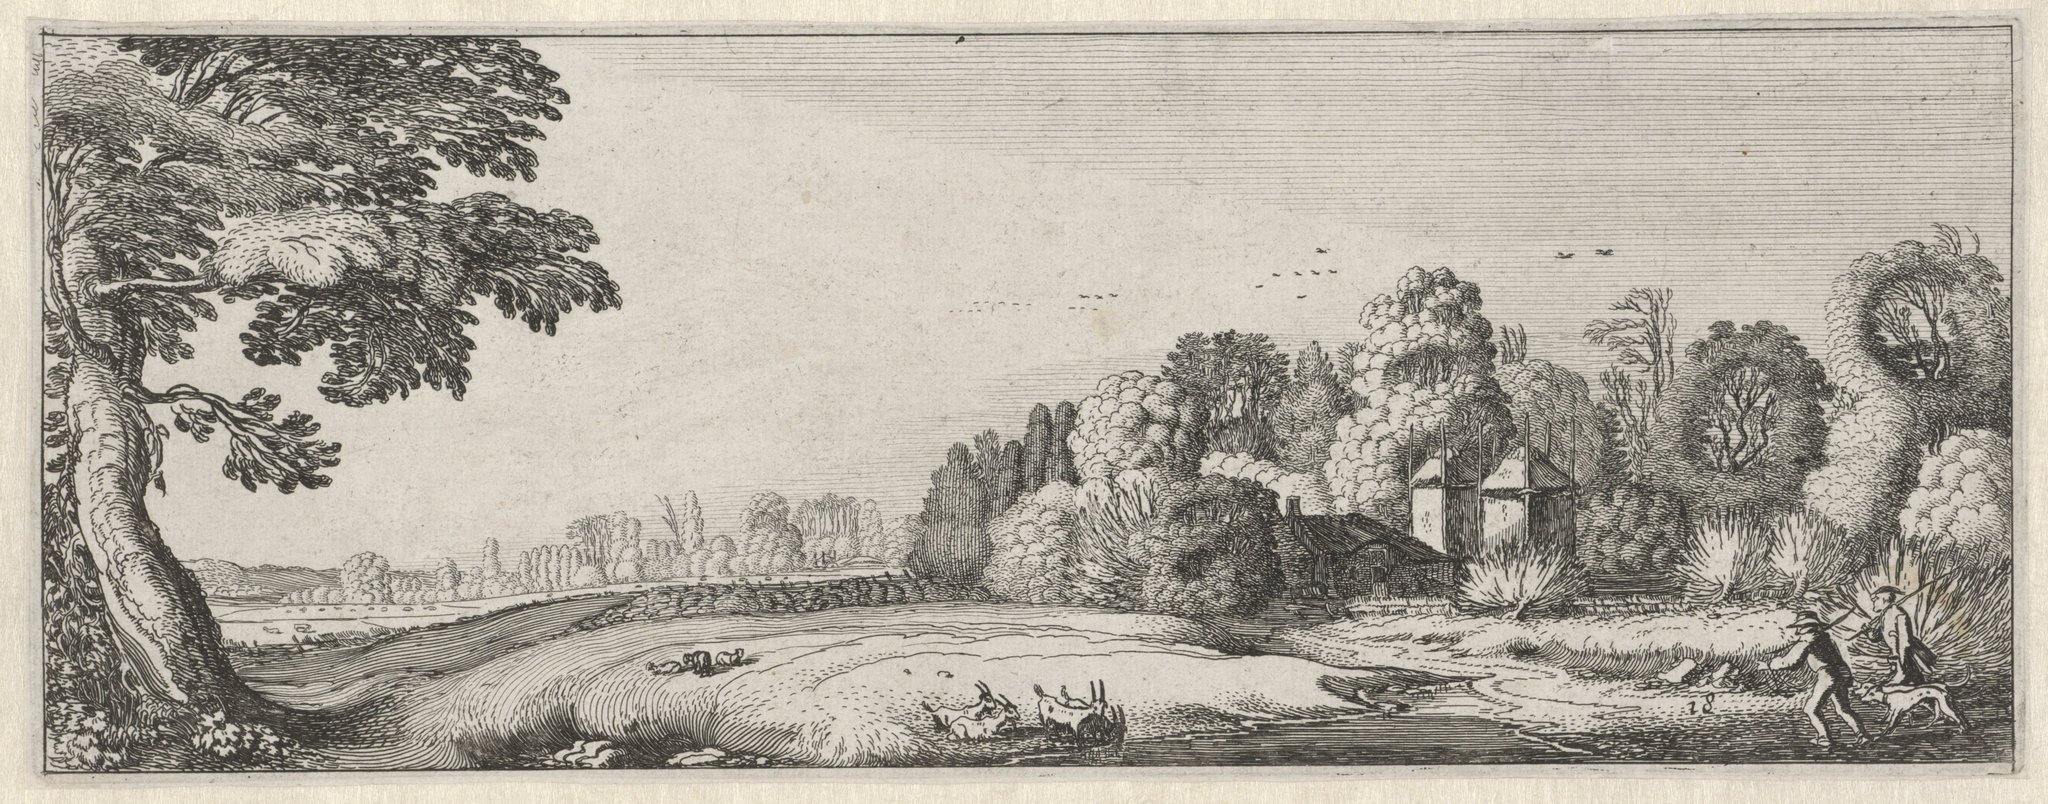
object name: print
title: Jagers met honden bij een boerderij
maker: jan van de velde (ii)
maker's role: draughtsman, painter, print maker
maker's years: 1593-1641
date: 1615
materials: paper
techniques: etching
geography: northern netherlands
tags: hunter, meadow, pasture, farm or solitary house in landscape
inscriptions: collector's mark: Lugt 240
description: Boerderij in een landschap. Rechts twee jagers met twee honden. Achttiende prent uit een serie van achttien.